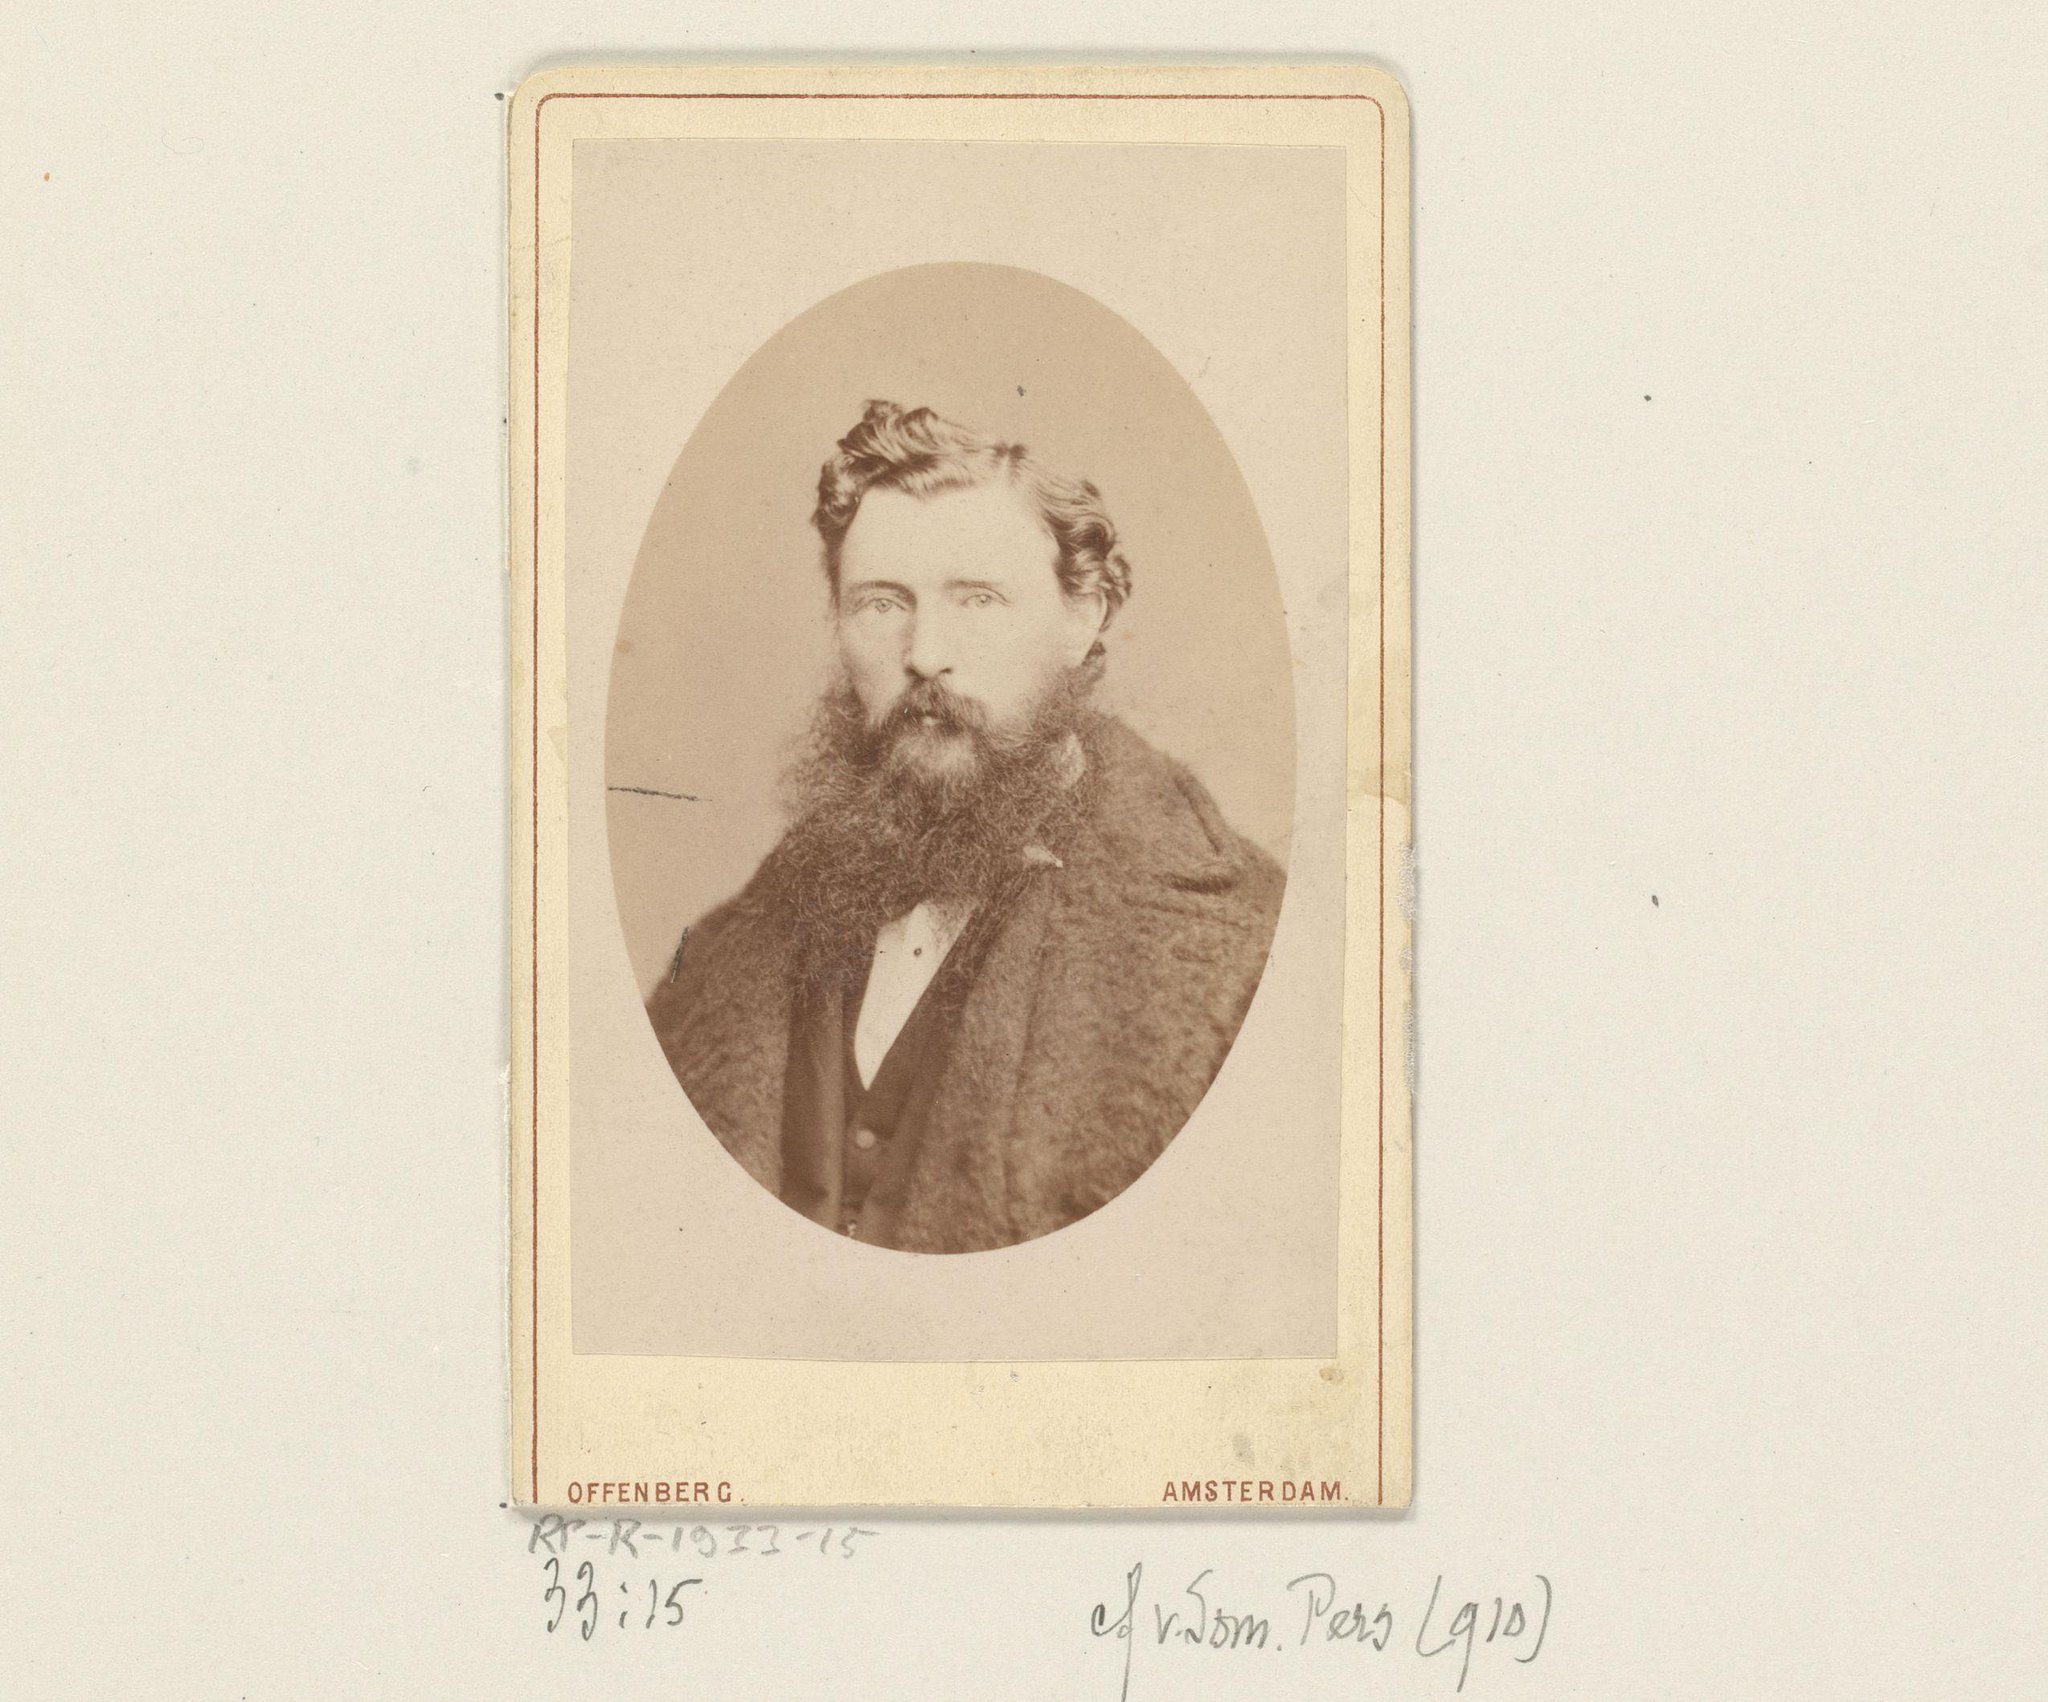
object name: carte de visite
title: Portret van Thomas François Burgers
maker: johannes wilhelmus franciscus offenberg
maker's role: fotograaf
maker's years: 1839-1919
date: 1867-1881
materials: cardboard, paper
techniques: albumen print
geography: amsterdam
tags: historical persons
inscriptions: number: ‘33:15’, inscription: ‘Offenberg/ Photographe (...) Amsterdam’